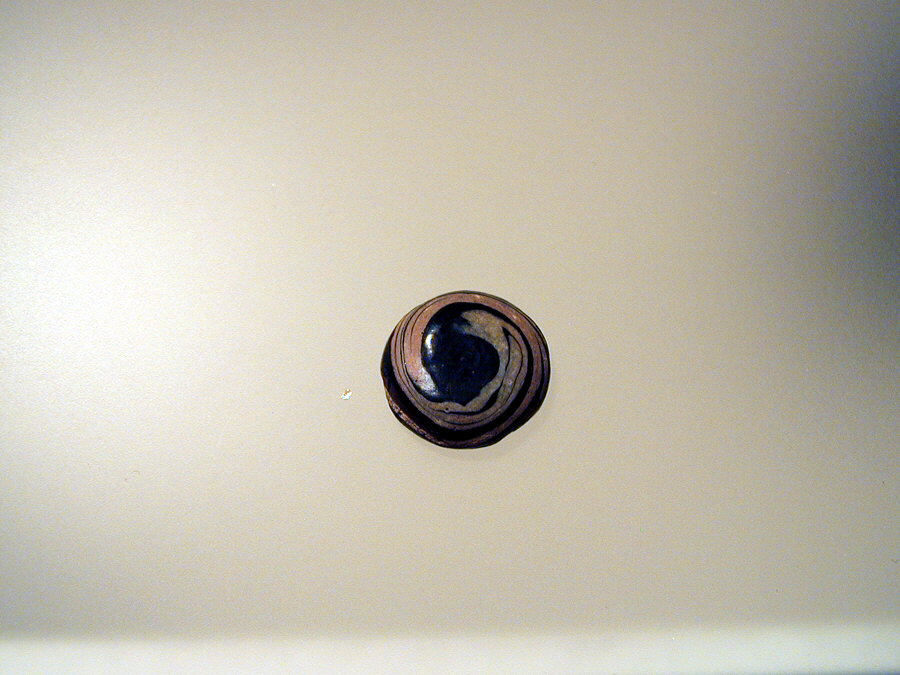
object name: pinhead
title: Glass pinhead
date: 7000 BCE-330 CE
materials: glass